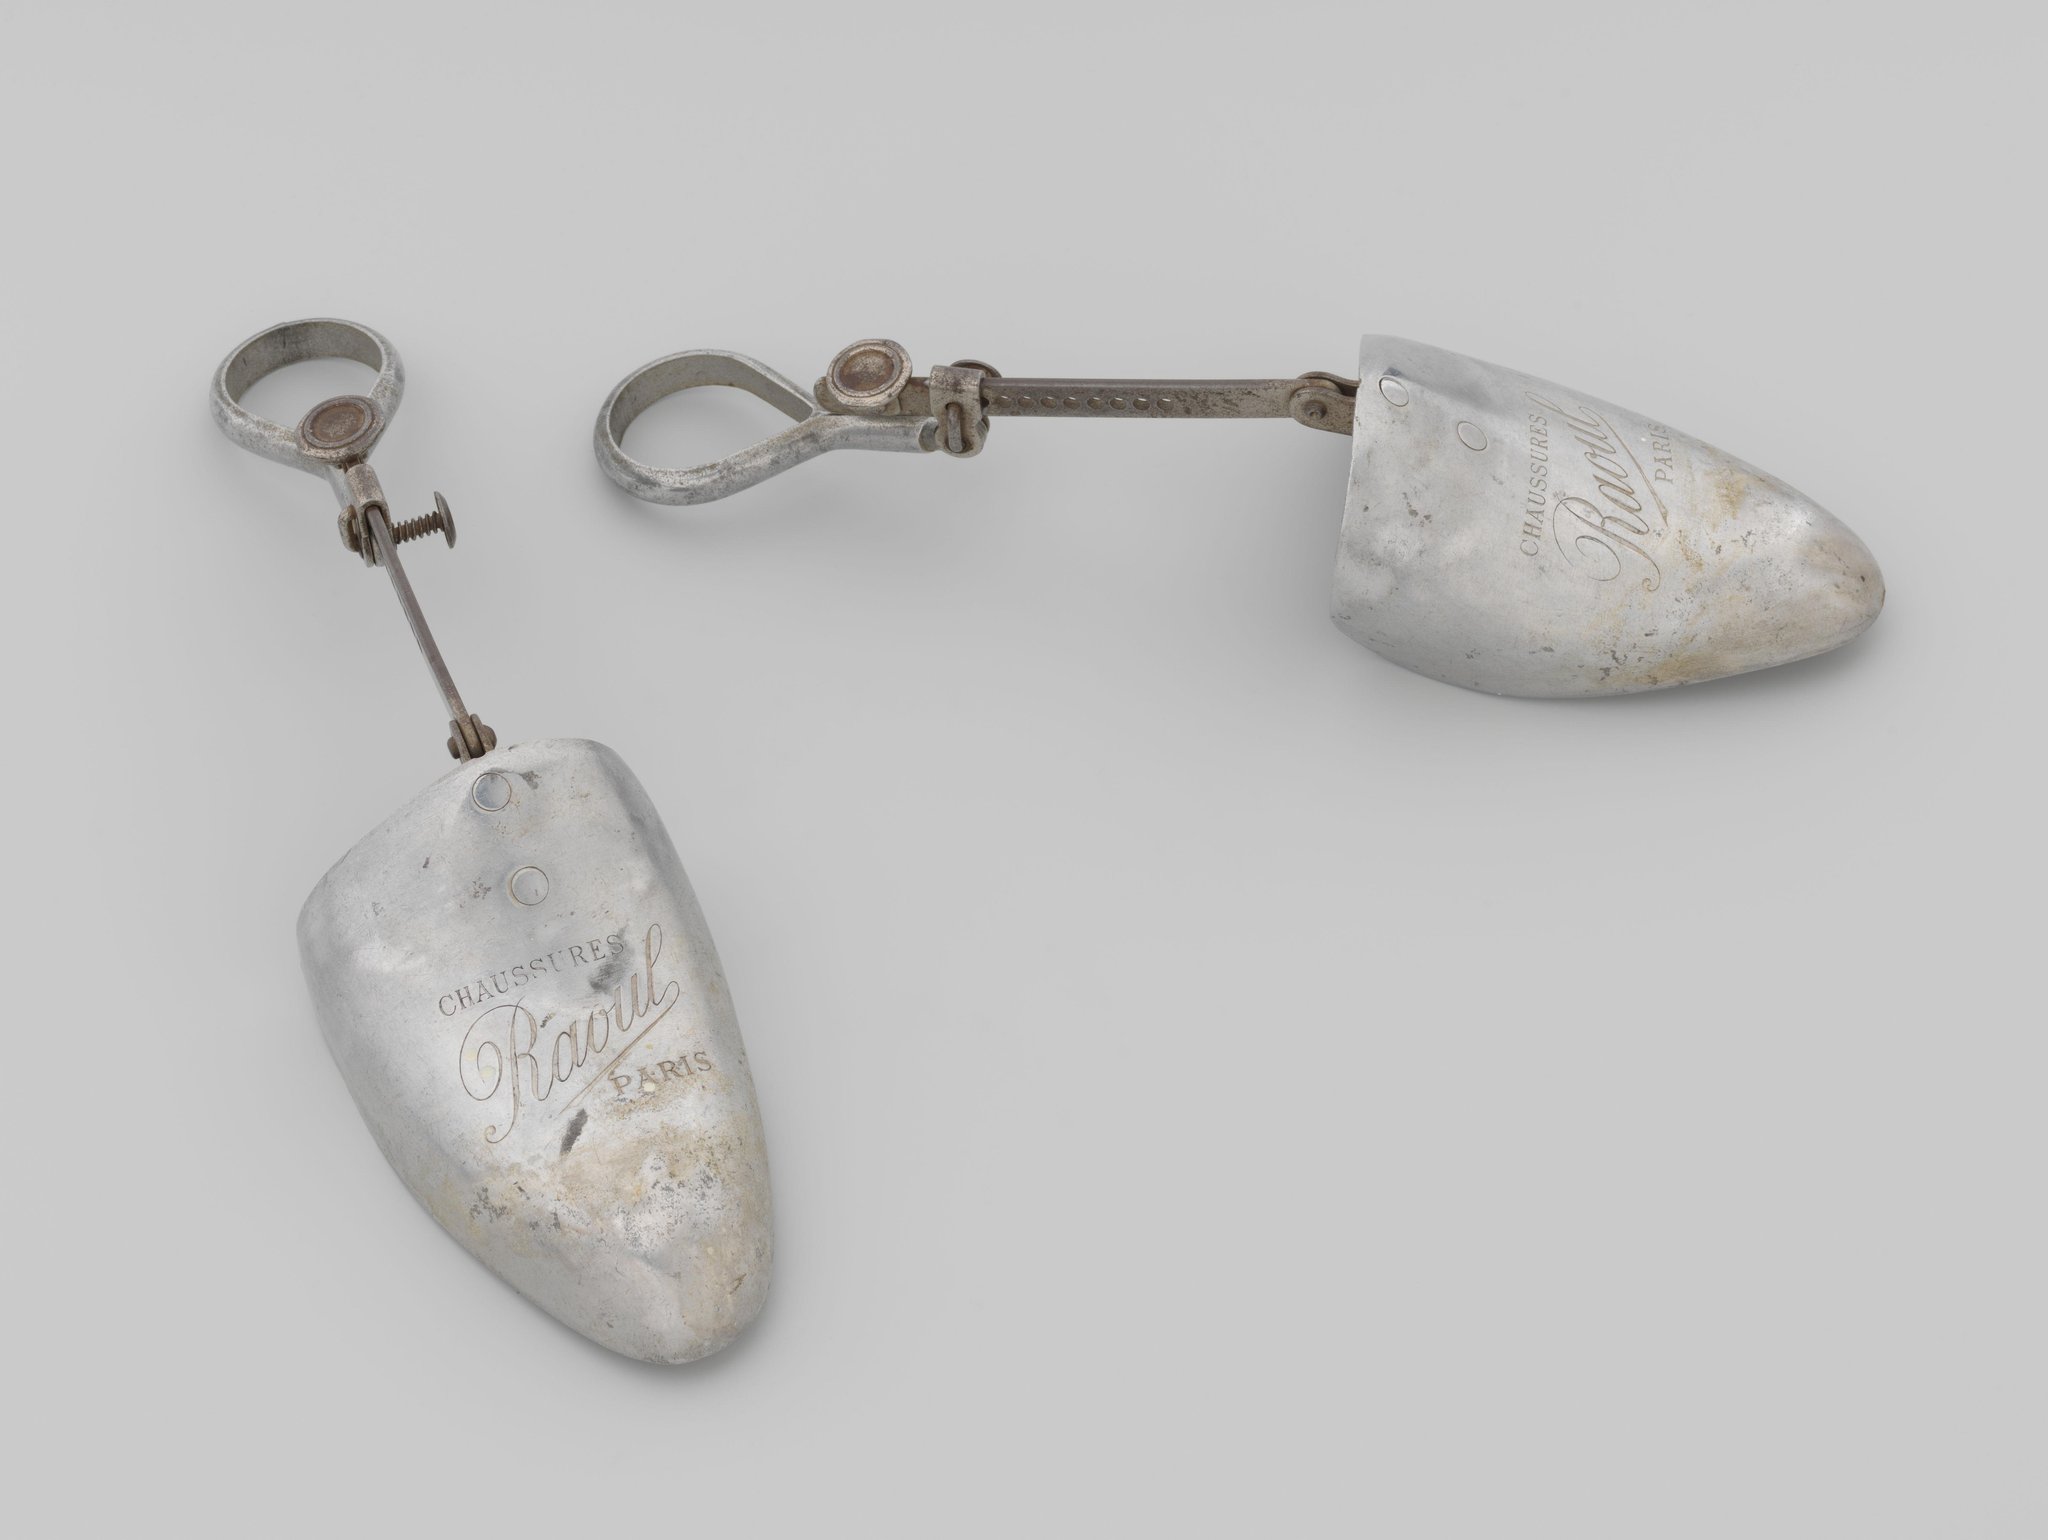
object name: shoe stretcher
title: Damesschoenspanner met verstelbare stang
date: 1920-1930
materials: metal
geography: paris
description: Rechter schoenspanner van metaal met verstelbare stang, adres: CHAUSSURES/RAOUL/PARIS.